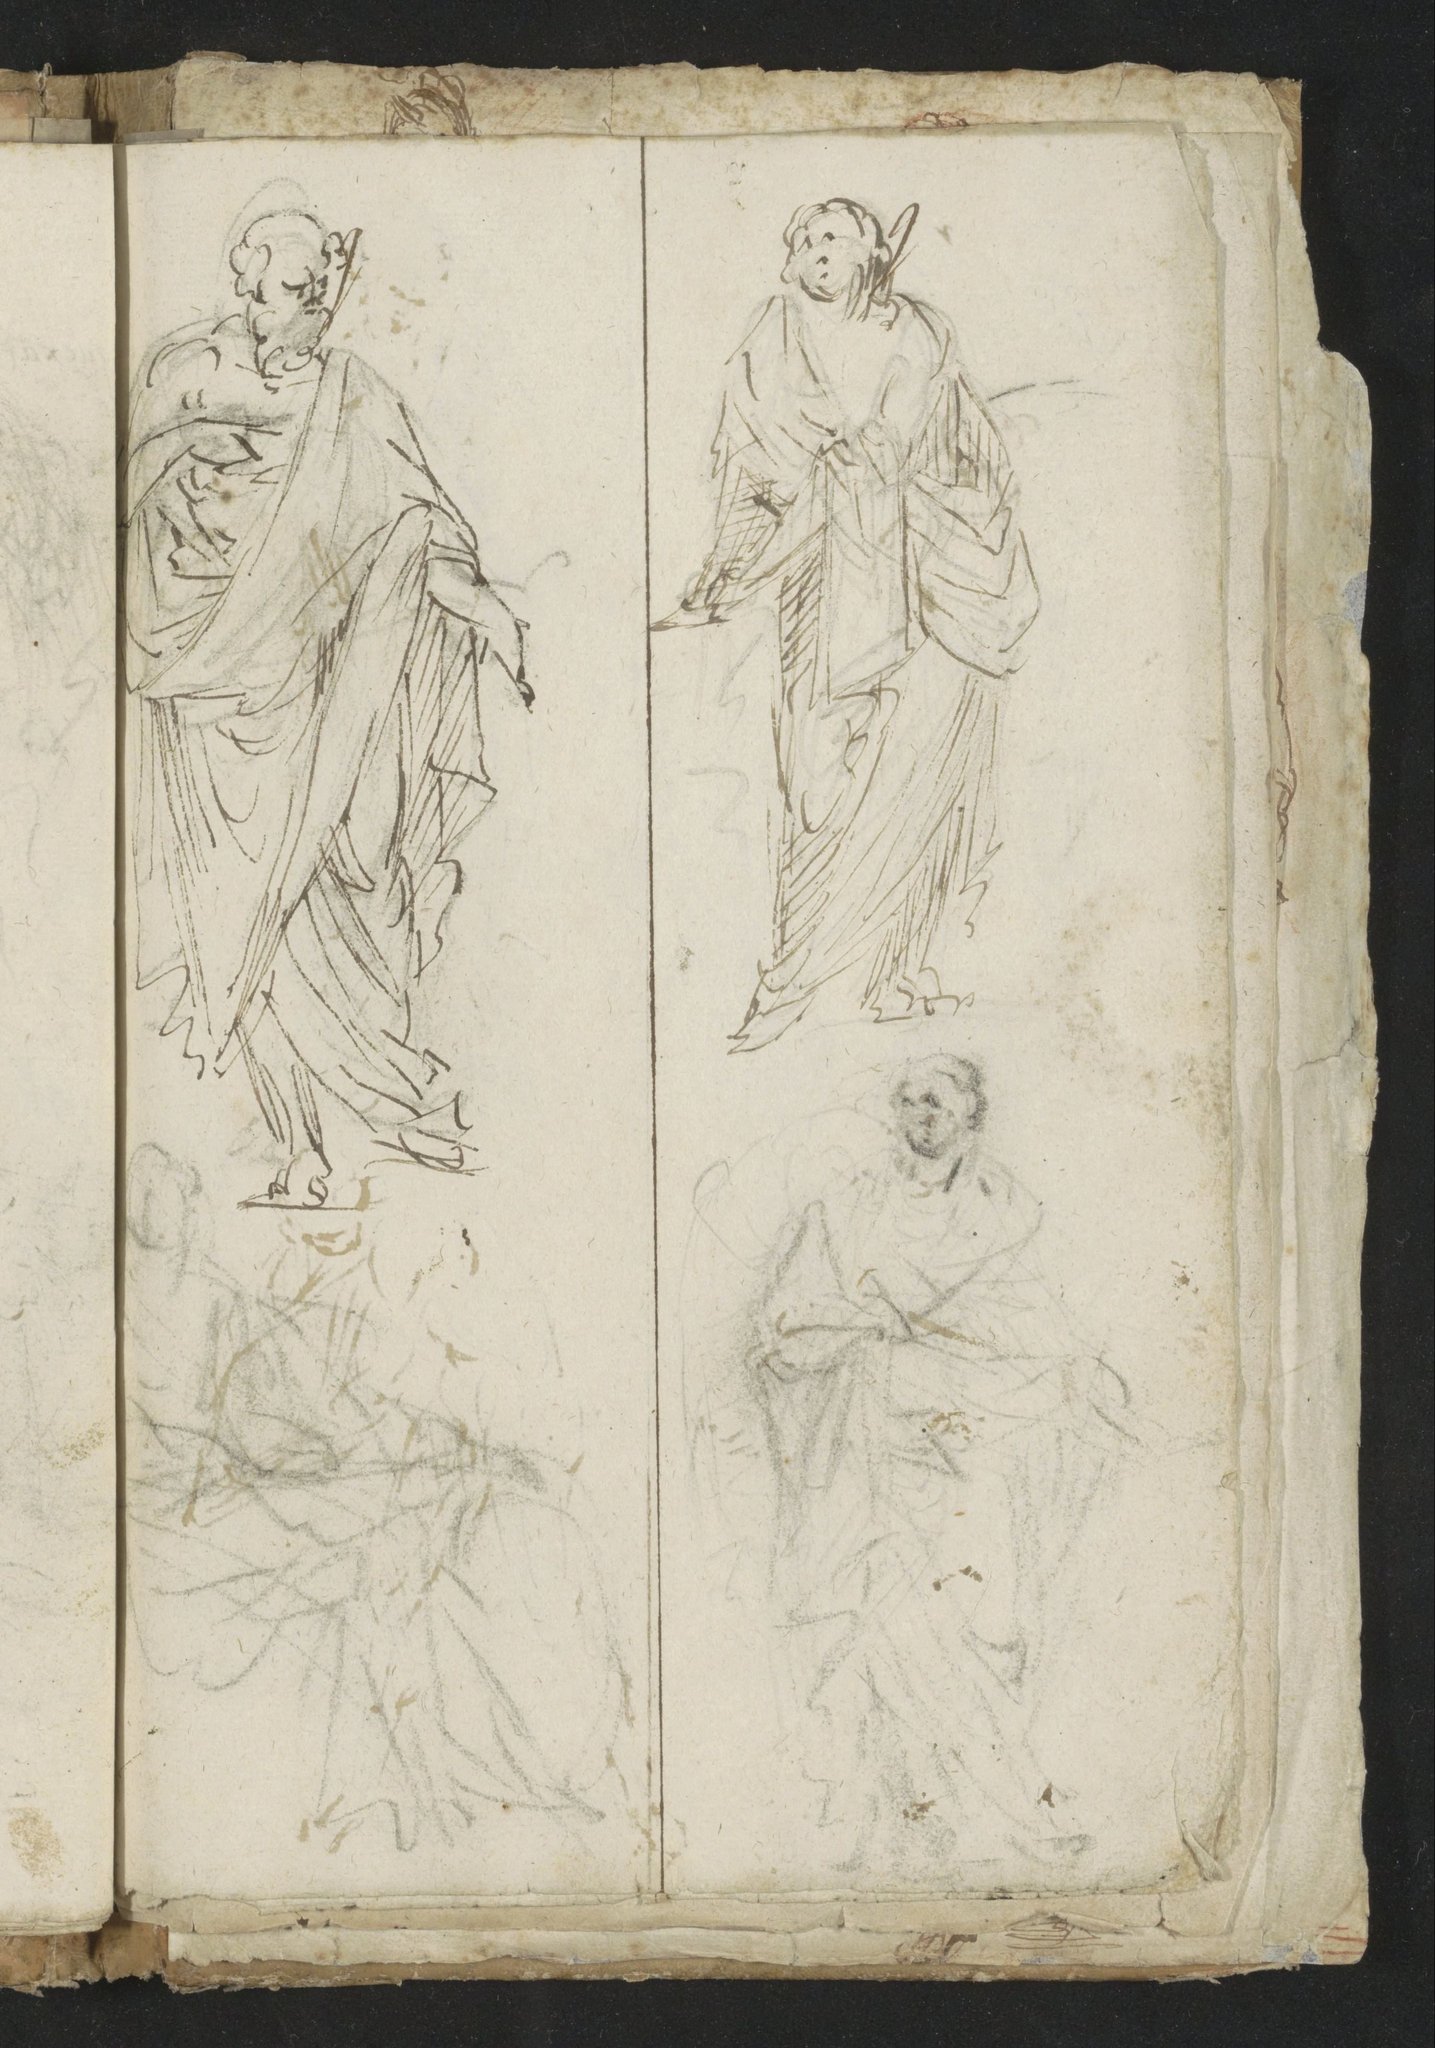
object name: sketchbook leaf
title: Figuren in toga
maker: Anonymous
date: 1658-1728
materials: chalk, ink, paper, pencil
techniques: pen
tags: standing figure, arm stretched sidewards - aa - both arms or hands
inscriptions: annotation: ‘q q’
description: Blad 31 recto uit een schetsboek met 33 bladen.